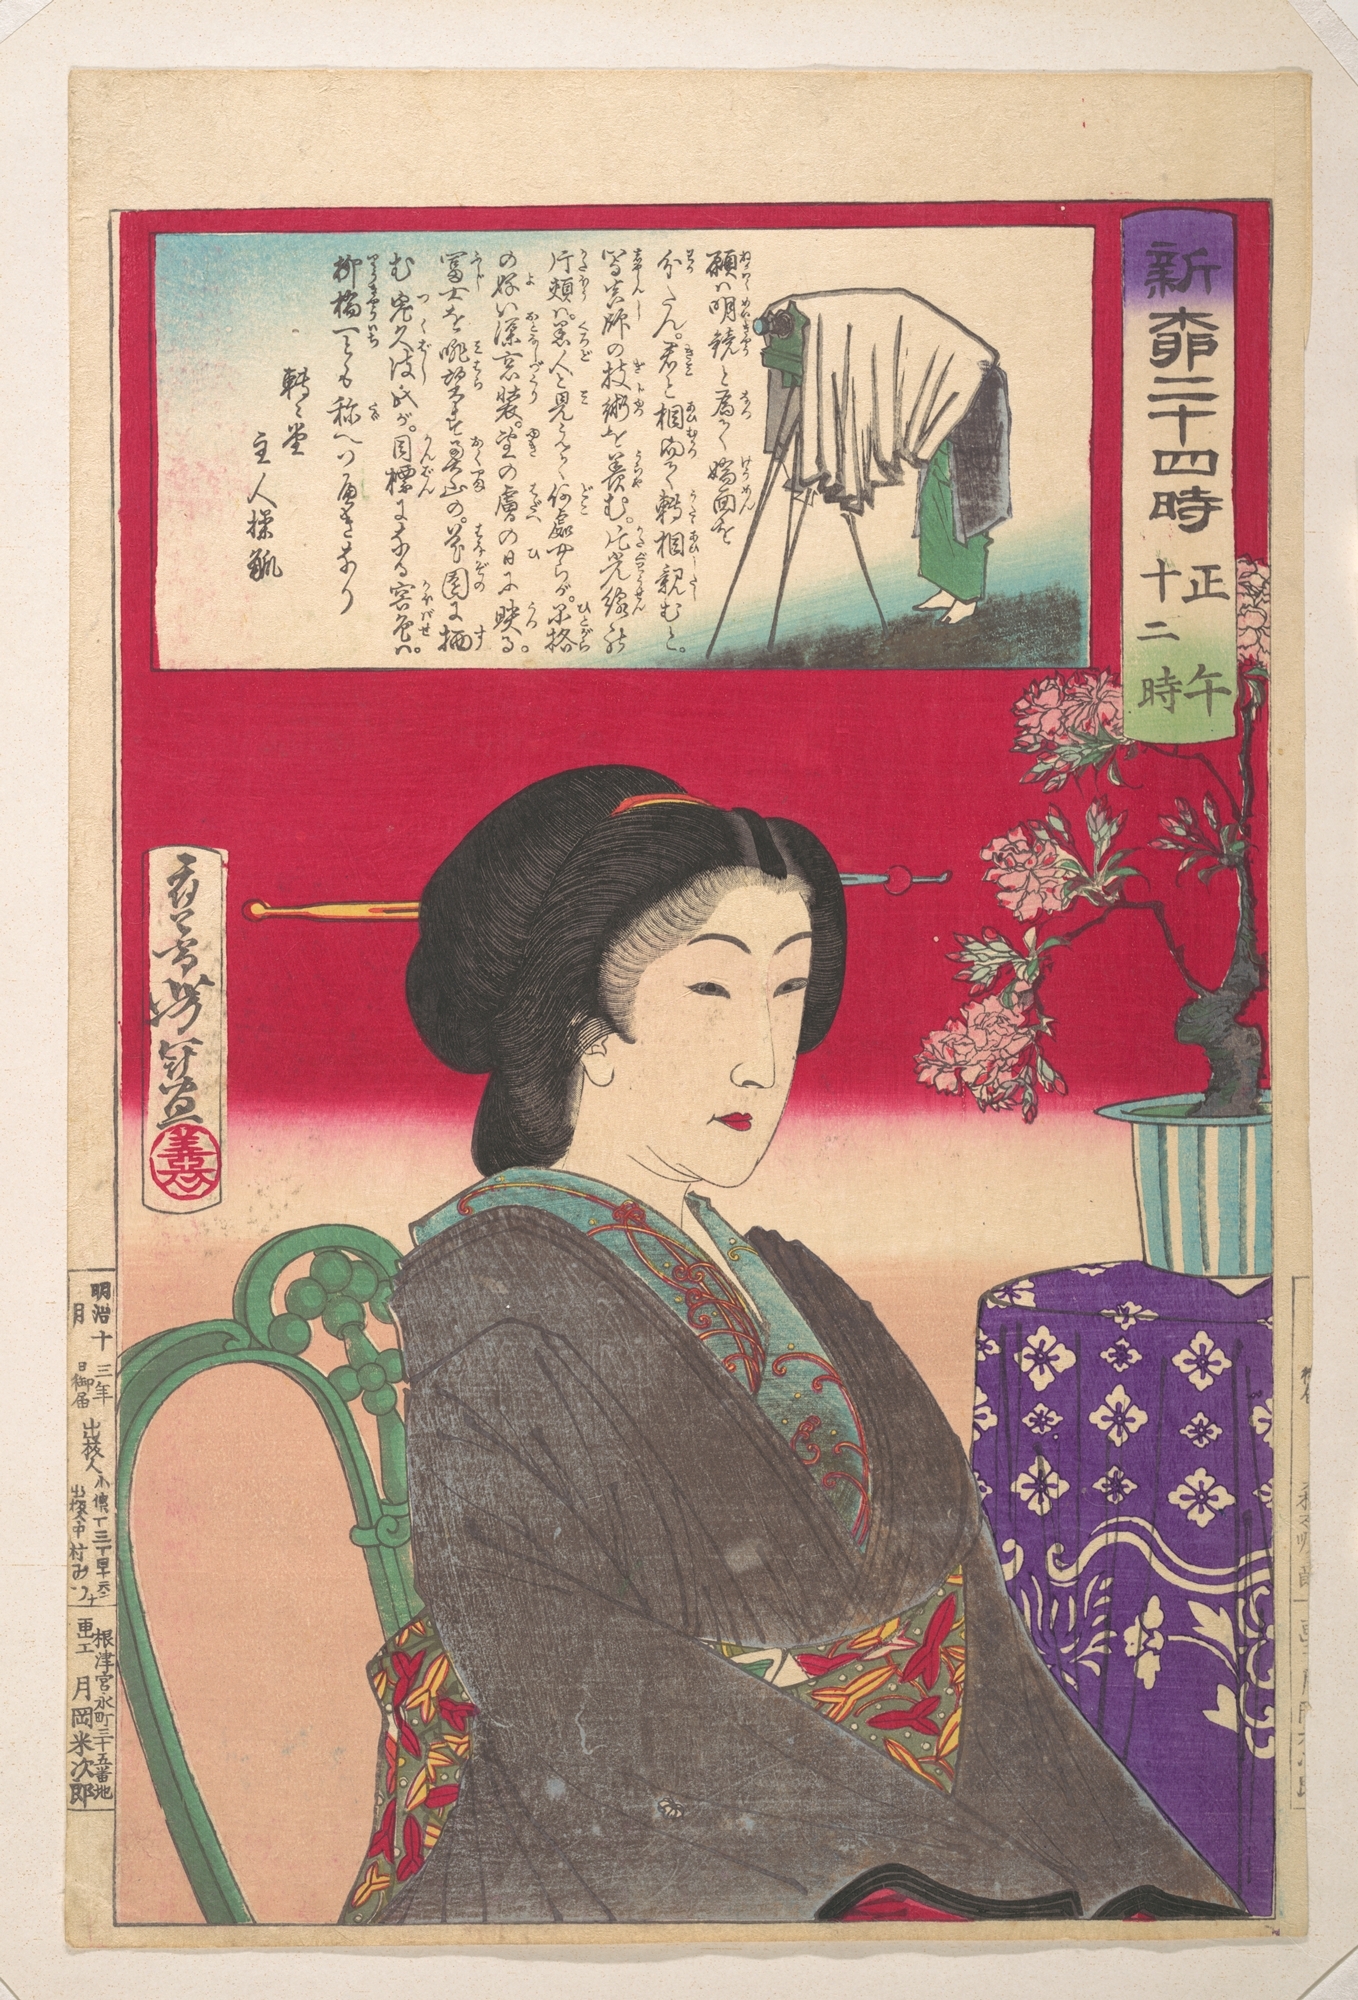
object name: print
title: Twenty-Four Hours at Shinbashi/Yanagibashi: 12 Noon. (Shinyanagi nijūyo-ji, gozen jūni-ji)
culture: japanese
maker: tsukioka yoshitoshi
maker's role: artist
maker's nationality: japanese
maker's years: 1839-1892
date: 1880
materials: ink, paper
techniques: woodblock print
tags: portraits,women,flowers